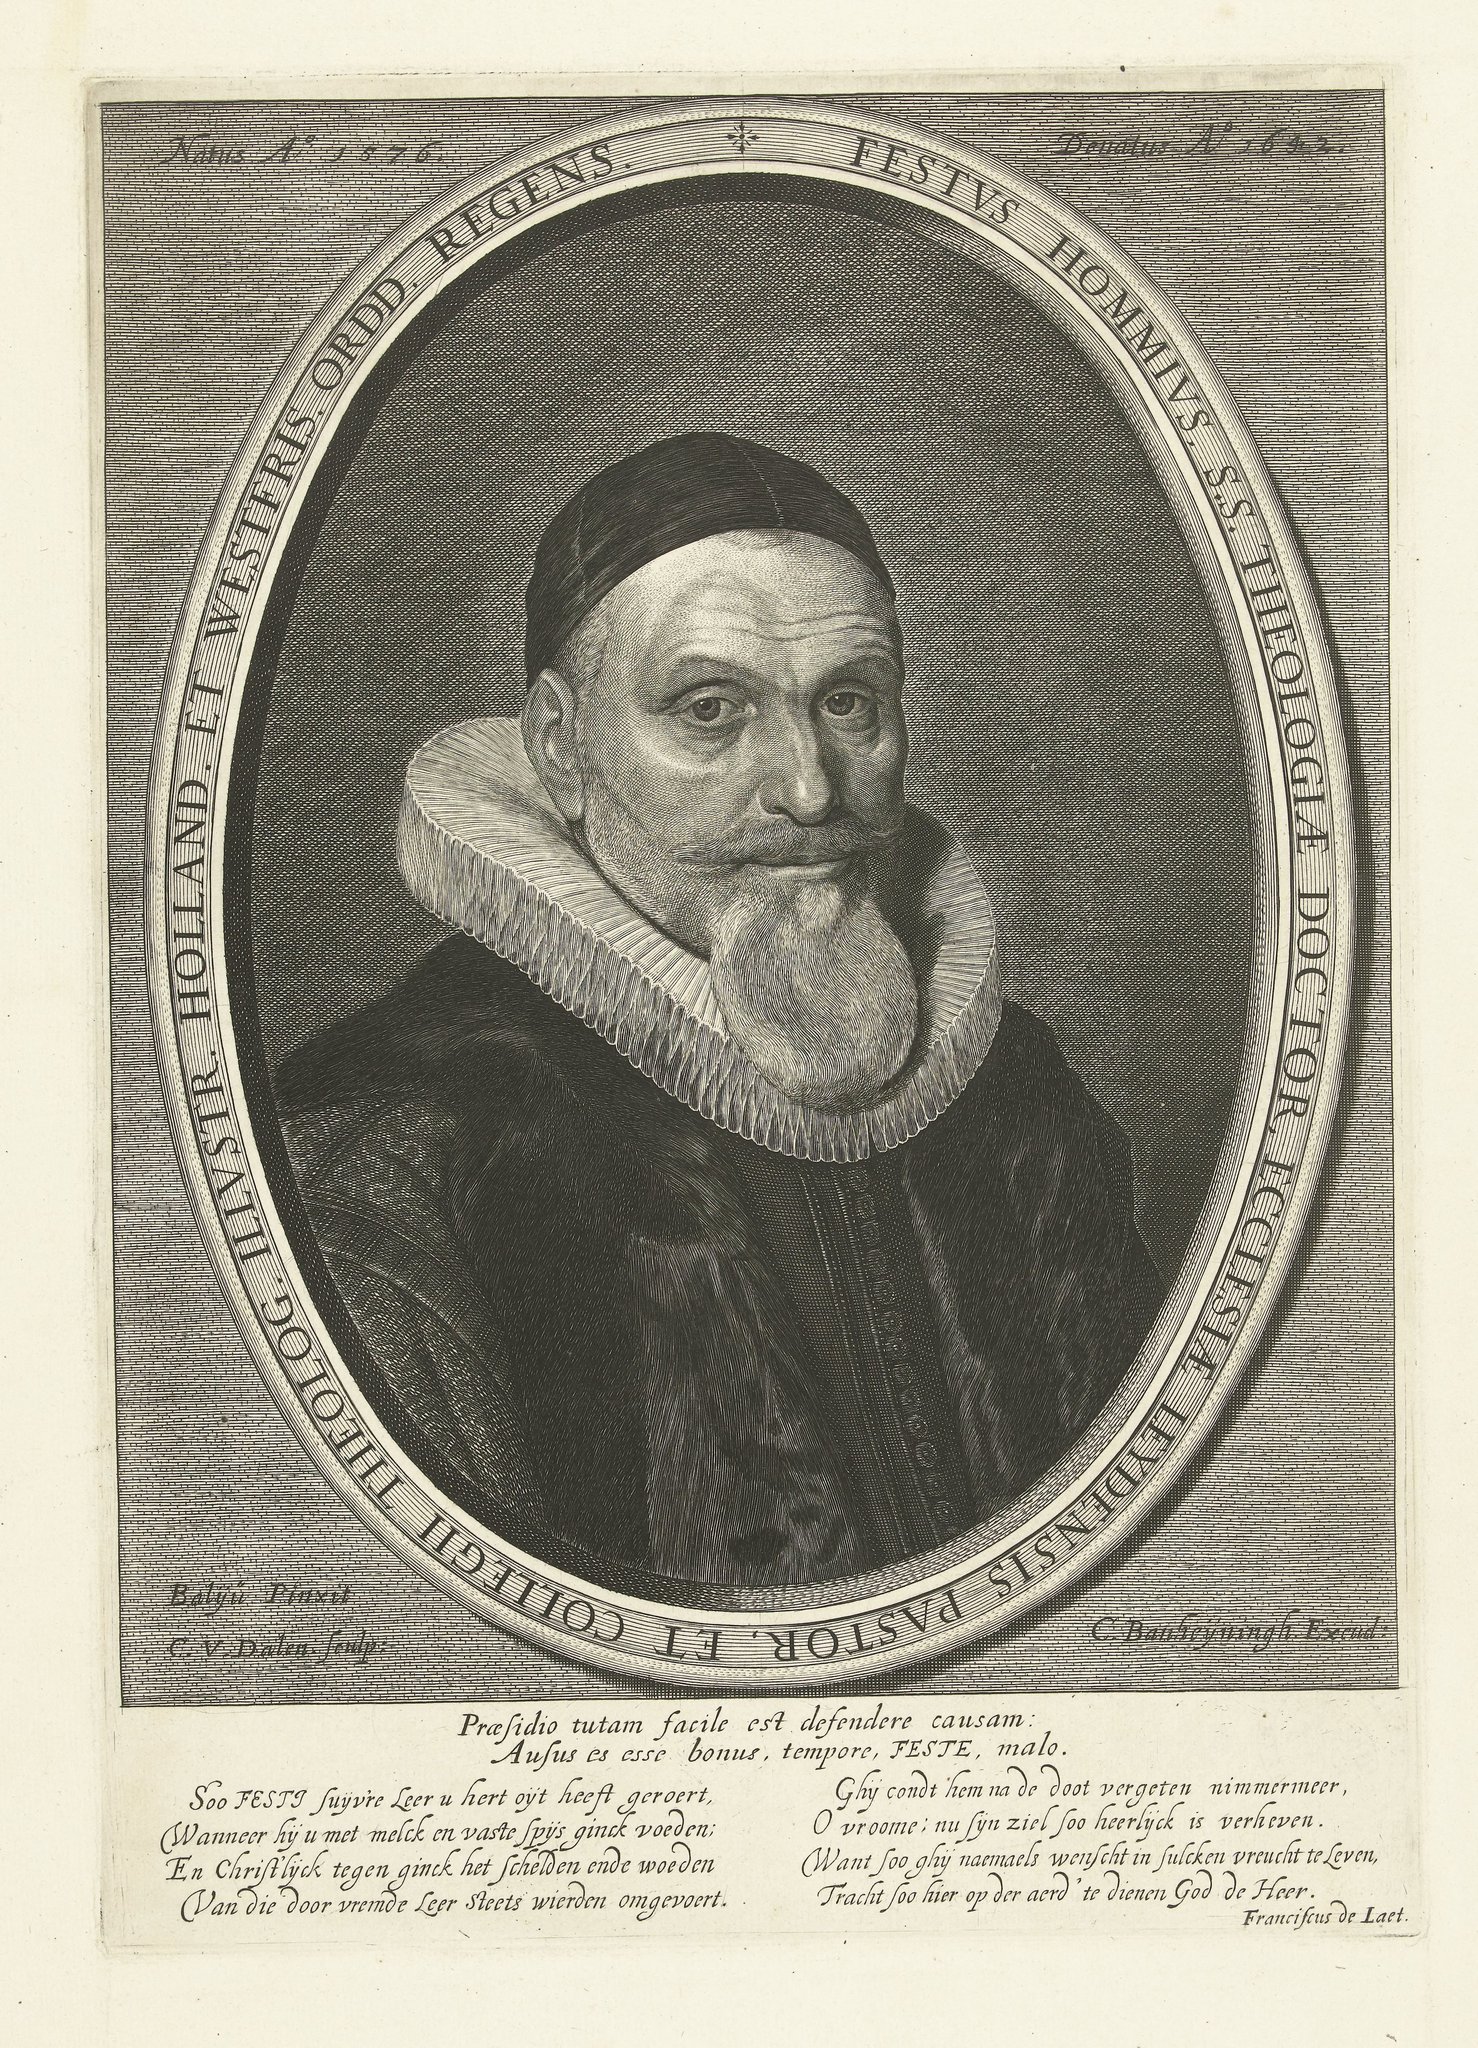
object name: print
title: Portret van Festus Hommius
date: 1612-1665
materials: paper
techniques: engraving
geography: amsterdam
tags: leiden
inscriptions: collector's mark: Lugt 240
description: Portret van Festus Hommius, predikant te Leiden. Borststuk in ovale omlijsting. In de marge een Nederlands vers van Franciscus de Laet.